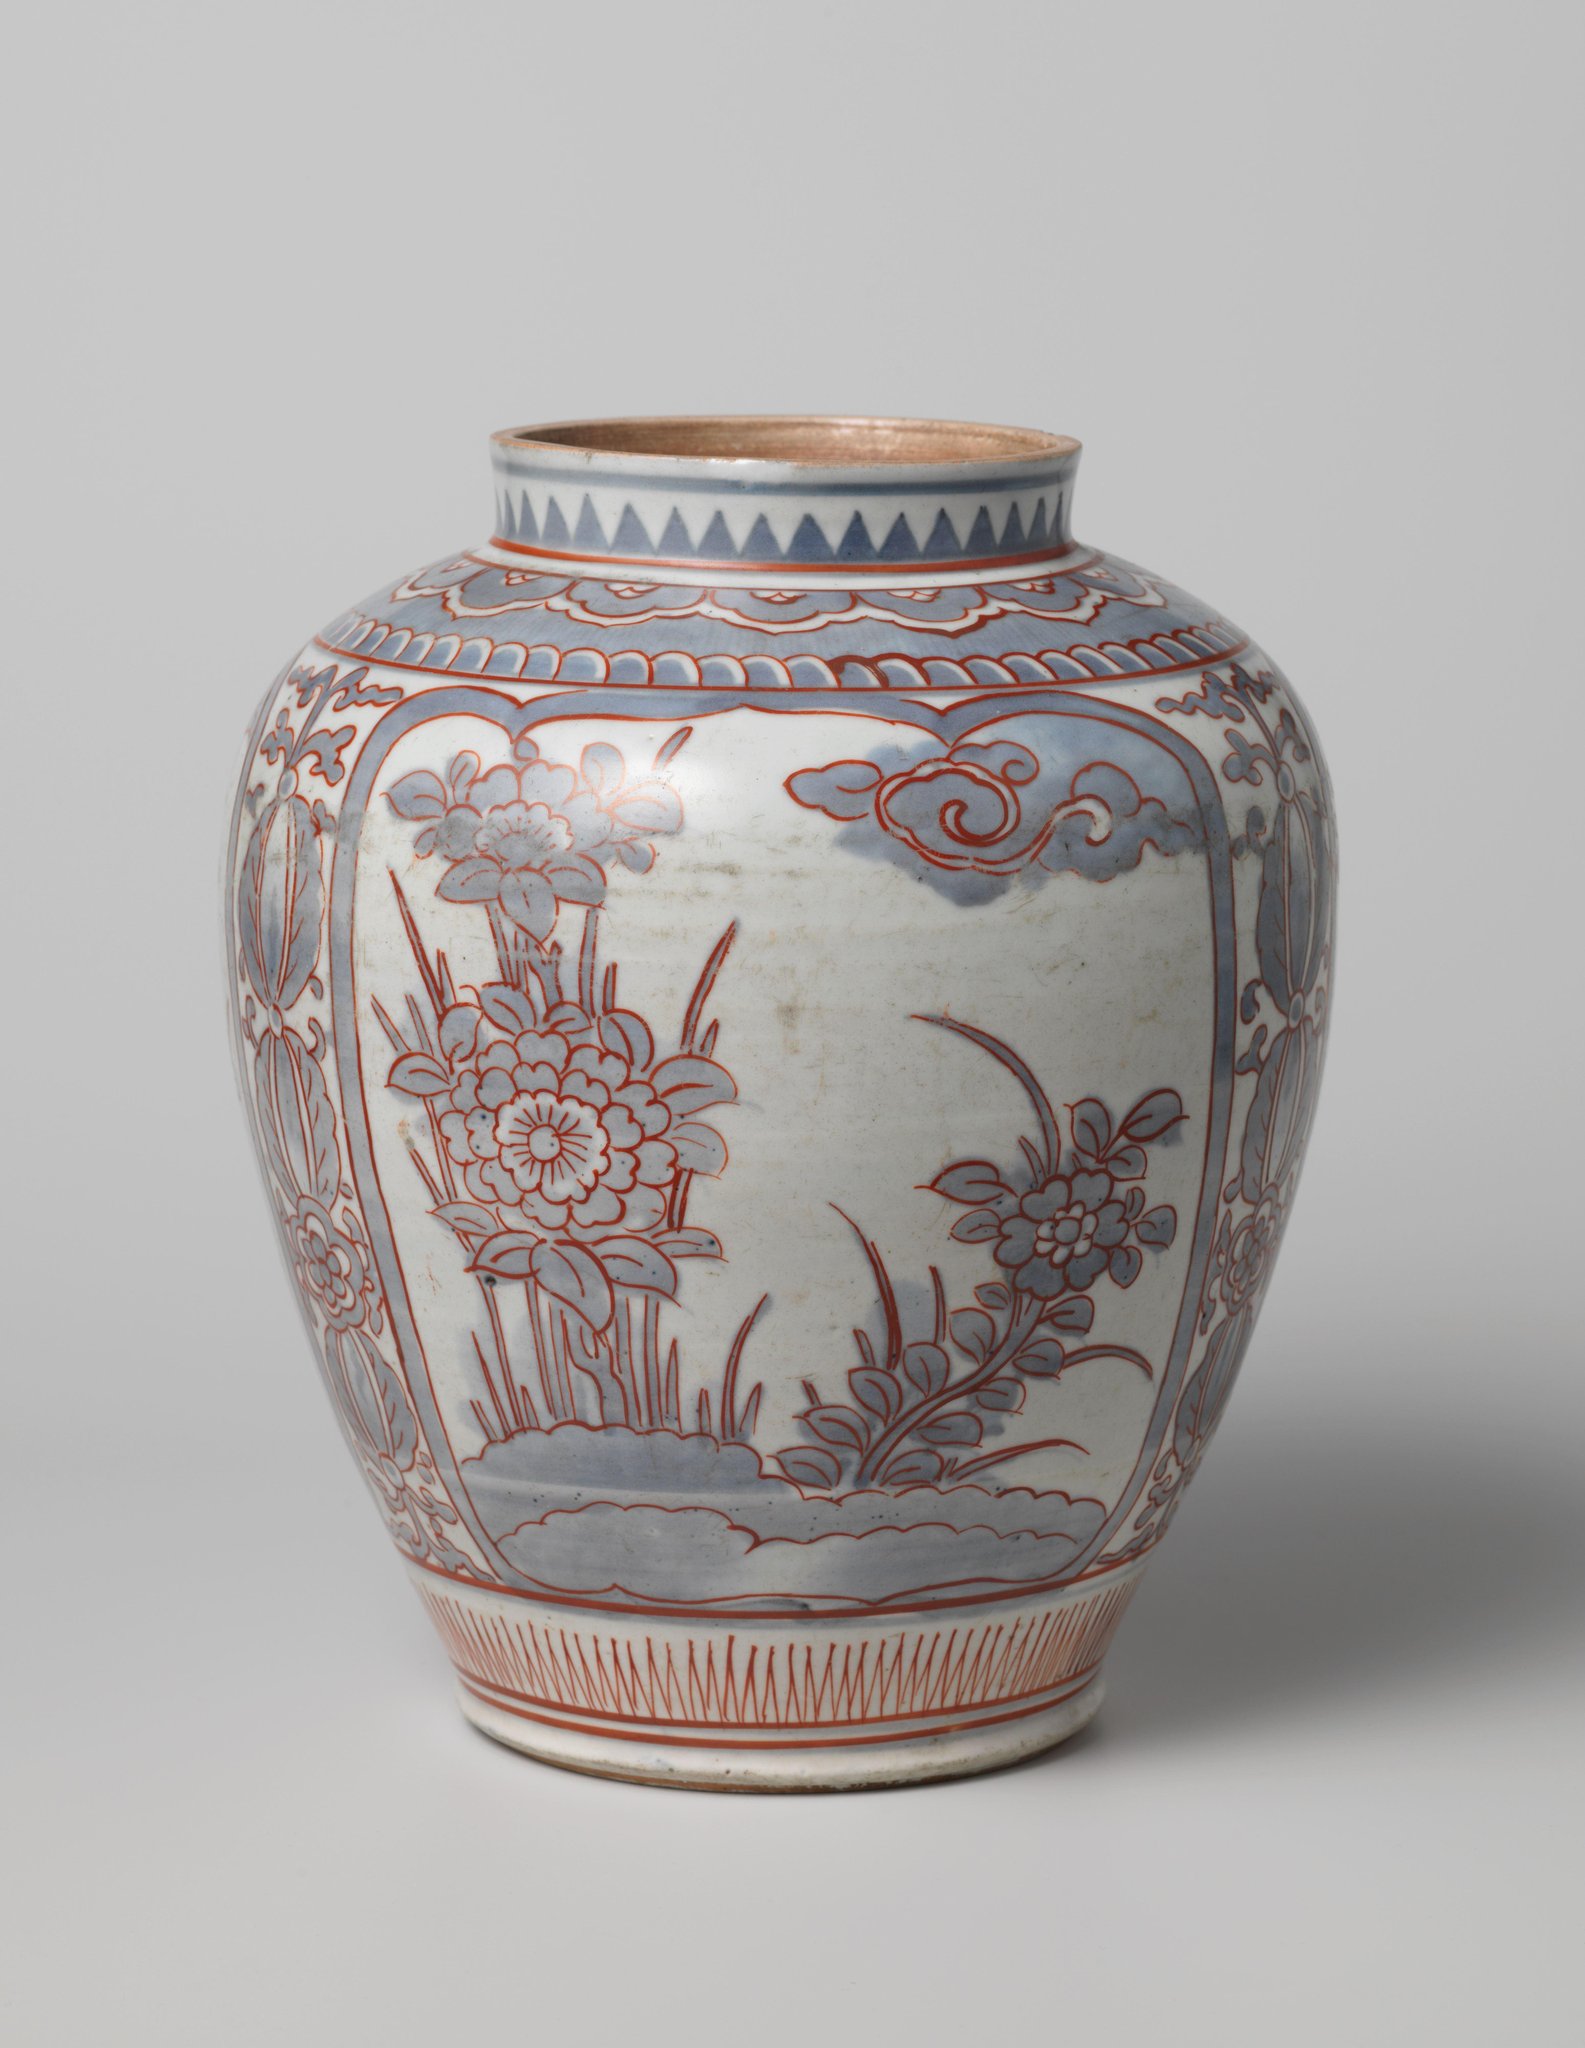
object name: pot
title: Ovoid jar with flowering plants in panels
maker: Anonymous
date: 1580-1620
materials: cobalt, glaze, paint, porcelain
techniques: firing, turning, vitrification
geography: japan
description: Eivormige pot van porselein, beschilderd in onderglazuur grijsblauw en ijzerrood. Op de wand drie grote, geschulpte cartouches met daarin bloeiende planten en een wolk; tussen de cartouches bladranken. Rond de voet een band met punten. De schouder en nek met een decoratieve band. Een chip in de rand. Porselein met onderglazuur blauw en koperrood.